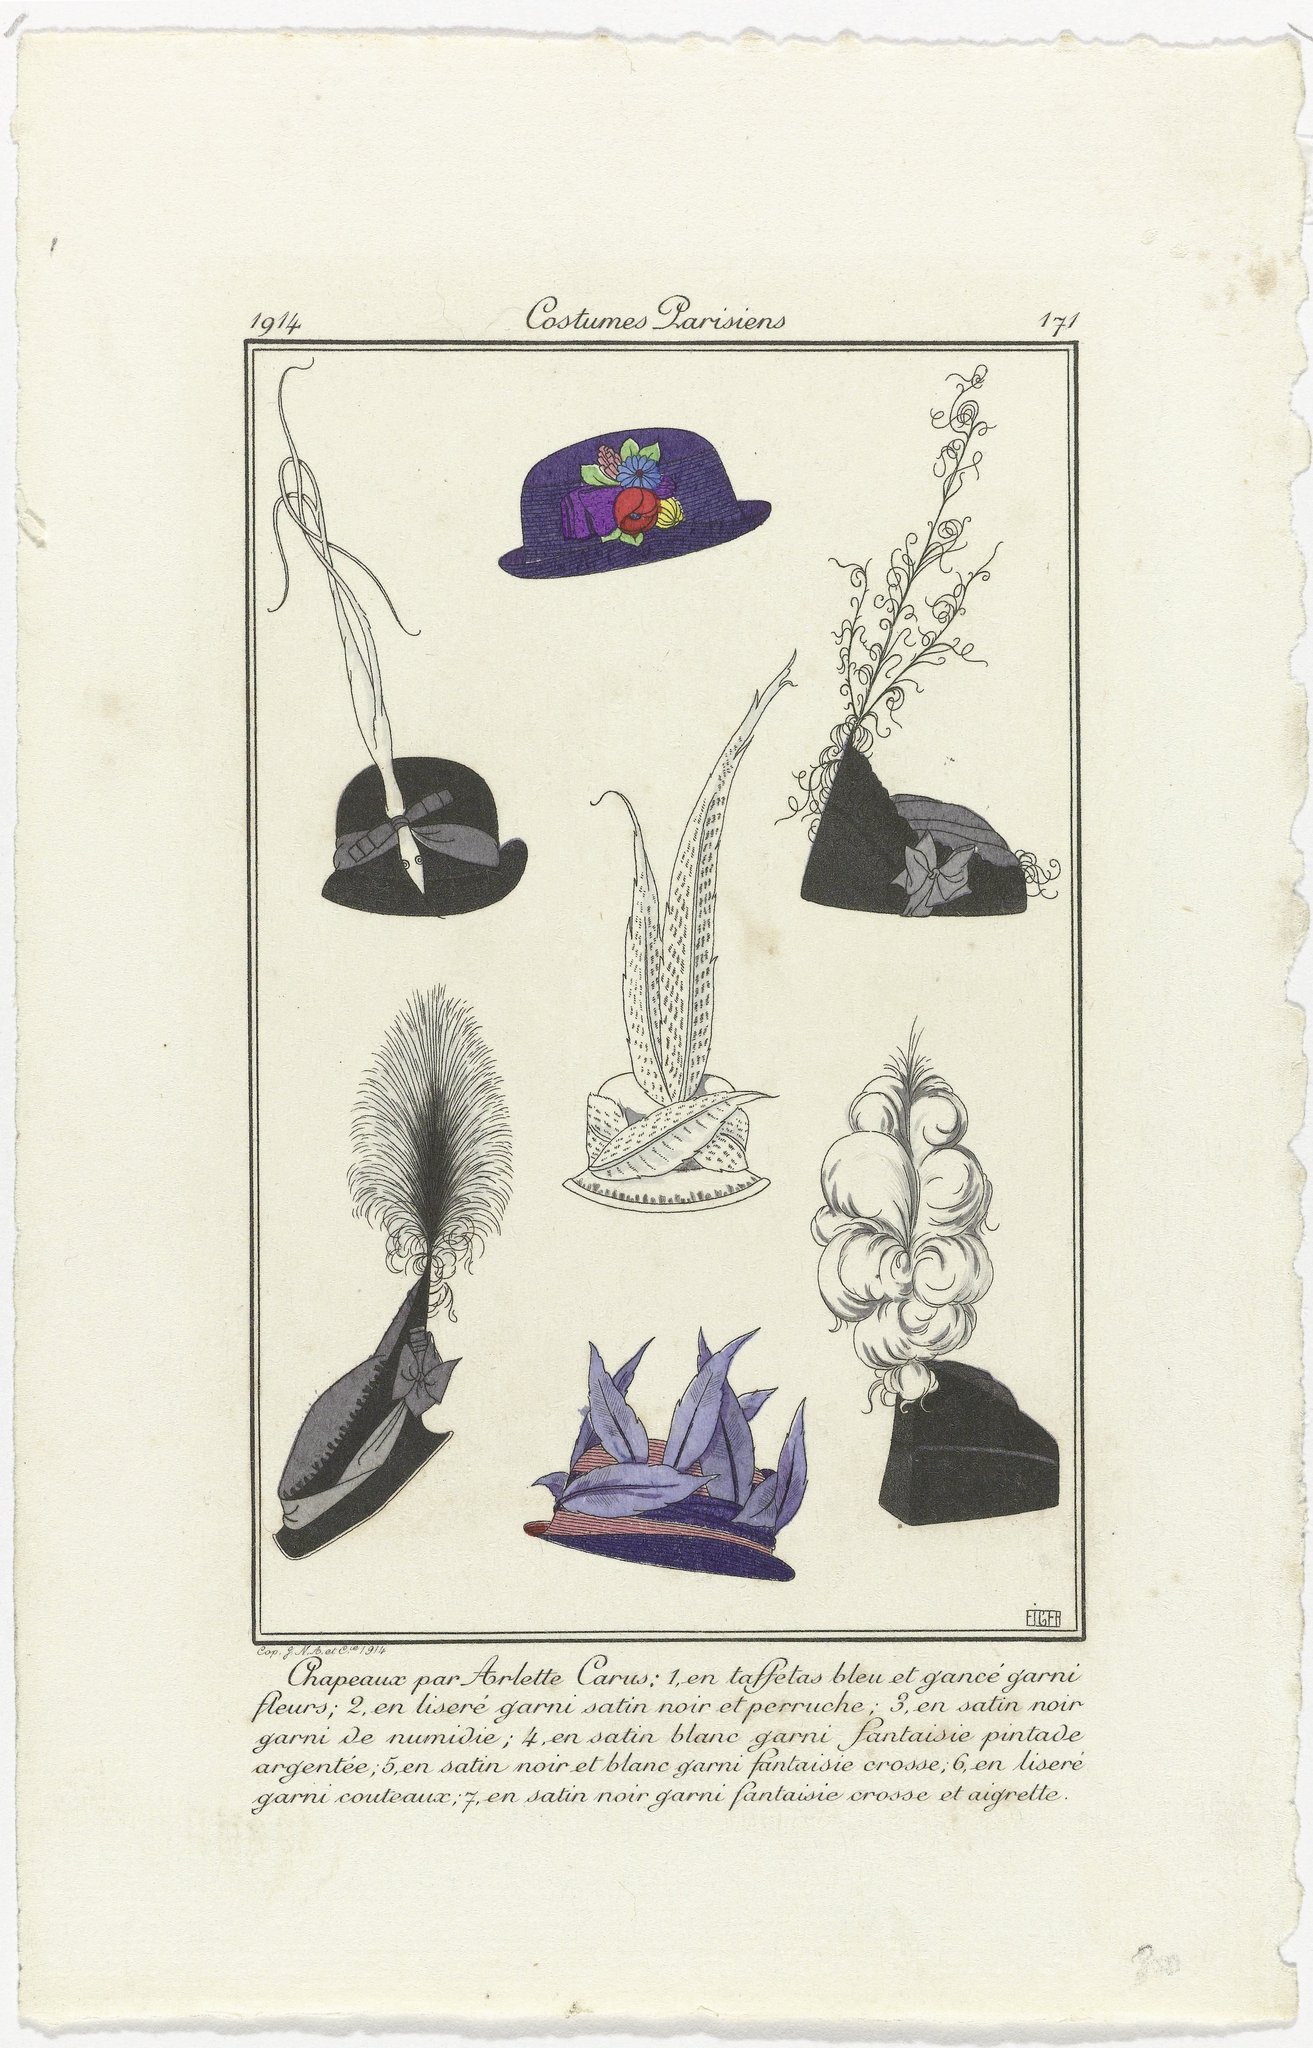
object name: fashion print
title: Accessories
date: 1914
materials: paper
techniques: engraving, hand coloring, pochoir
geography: paris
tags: fashion plates, head-gear: hat (+ women's clothes), head-gear: hat (+ feathers used for clothes)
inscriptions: caption: ‘Chapeaux par Arlette Carus; 1, en taffetas bleu et gancé garni fleurs; 2 en liseré garni satin noir et perruche; 3, en satin noir garni de numidie; 4, en satin blanc garni fantaisie pintade argentée; 5, en satin noir et blanc garni fantaisie crosse; 6, en liseré garni couteaux; 7, en satin noir garni fantaisie crosse et aigrette.’, inscription: ‘Cop. J. N. A. et Cie 1914’, title: ‘Costumes Parisiens’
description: Fans, parasols, opera gloves, fashionable hats, small toques garnished with feathers, wristwatches, compact bracelets, and luxuriously crafted lighters: there was a dazzling variety of accessories in the 1920s. Small bags could be suspended from a belt, or a glove. Walking sticks and the shafts of umbrellas and parasols were often embellished with carving clearly inspired by African and Indian art. And Russian influence was evident when it came to combs made of mother-of-pearl and ivory.